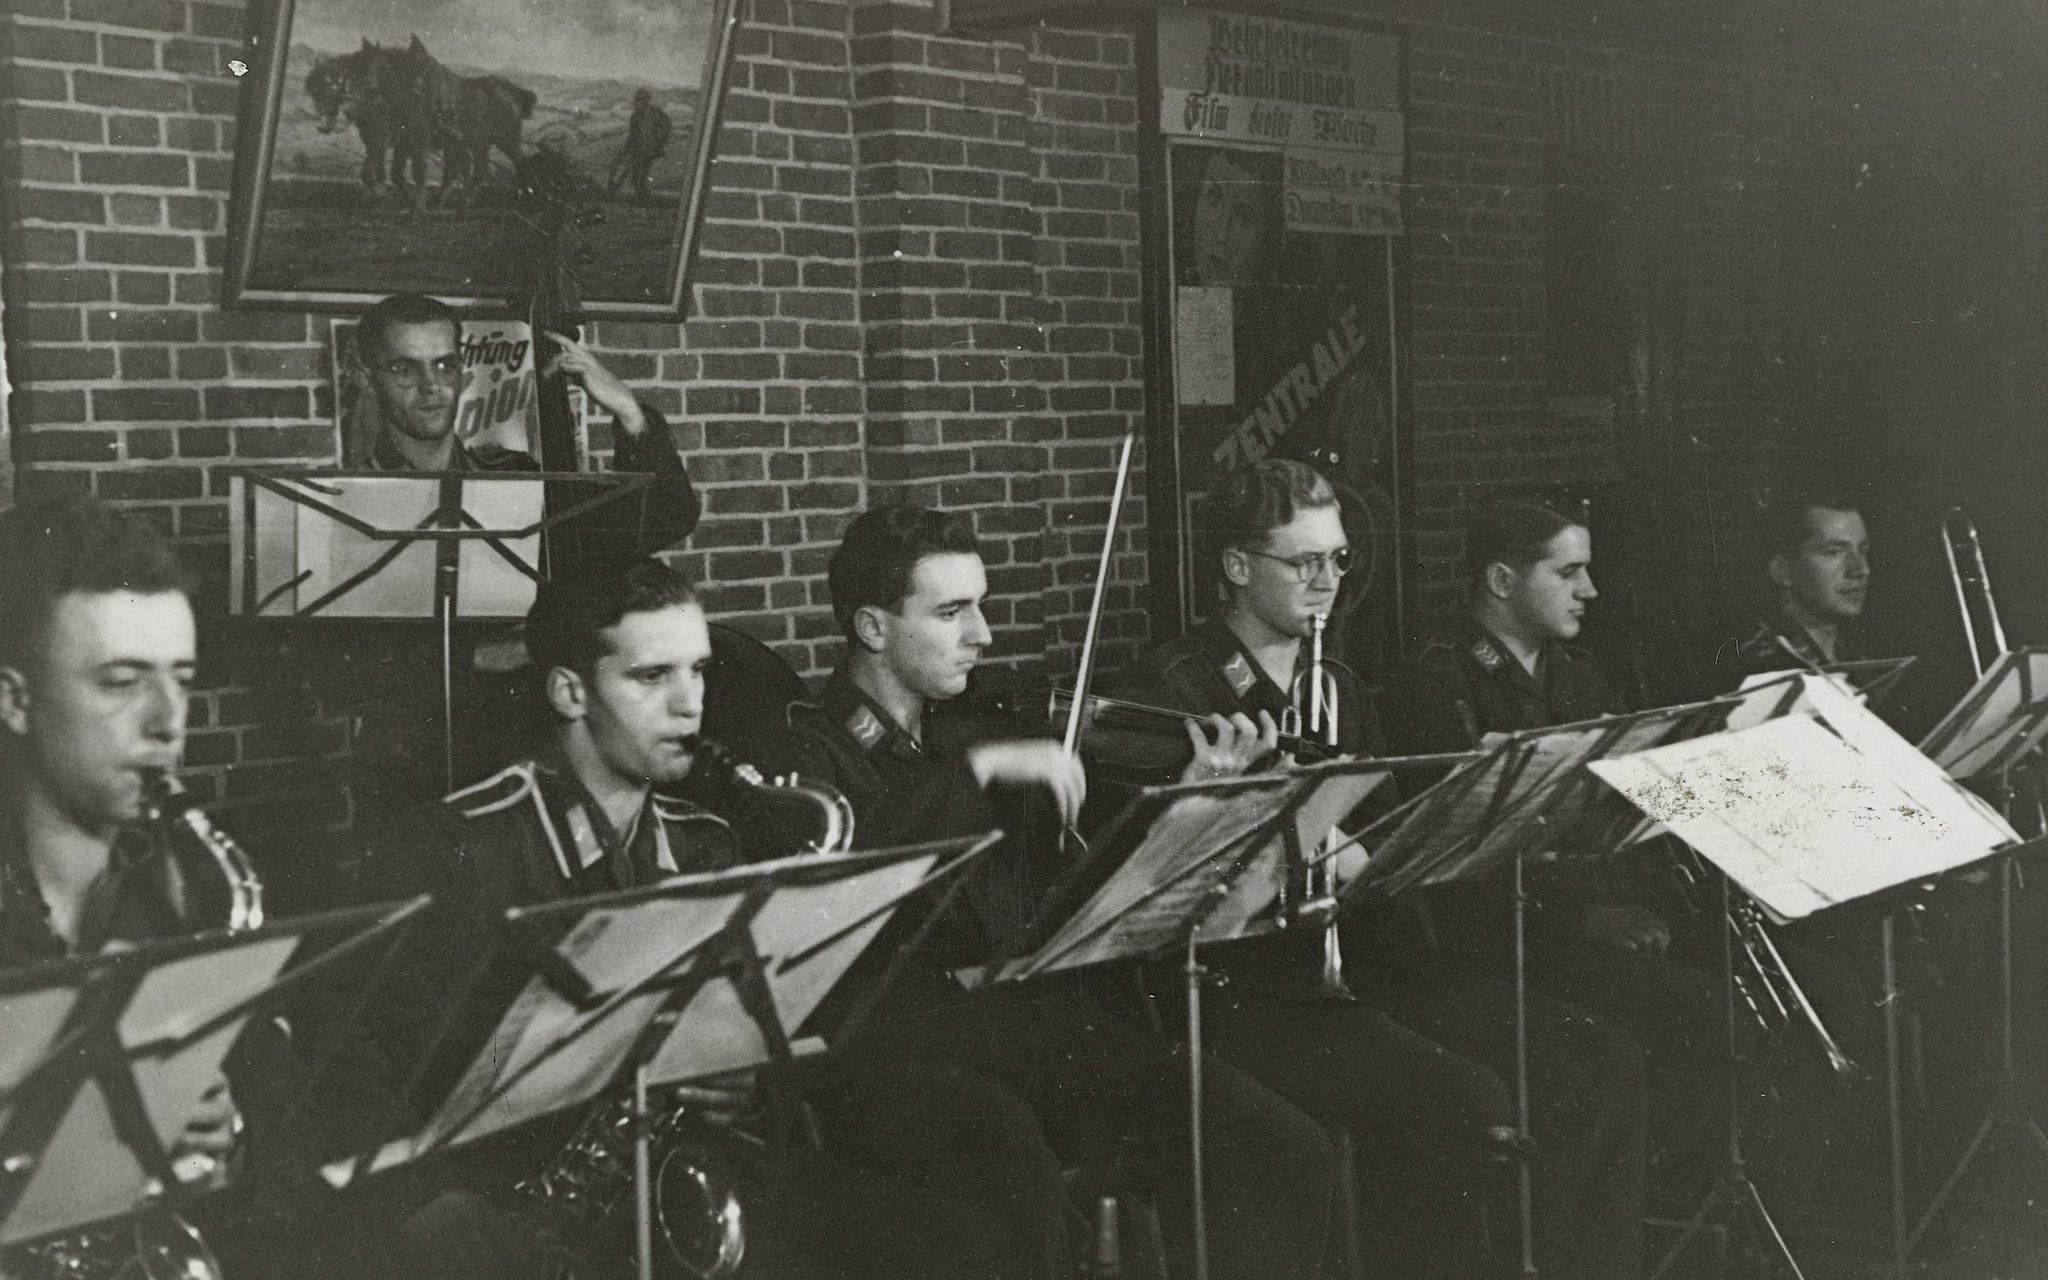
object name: photograph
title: Orkest van de Luftwaffe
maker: Anonymous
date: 1941-1942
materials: photographic support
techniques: gelatin silver print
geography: netherlands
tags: military band, occupation ~ war, netherlands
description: Luftwaffe militairen spelen muziek, op blaas- en snaarinstrumenten. Voor hen een standaard met muziek. Aan de muur een plaat van een ploegende boer en een filmaffiche.